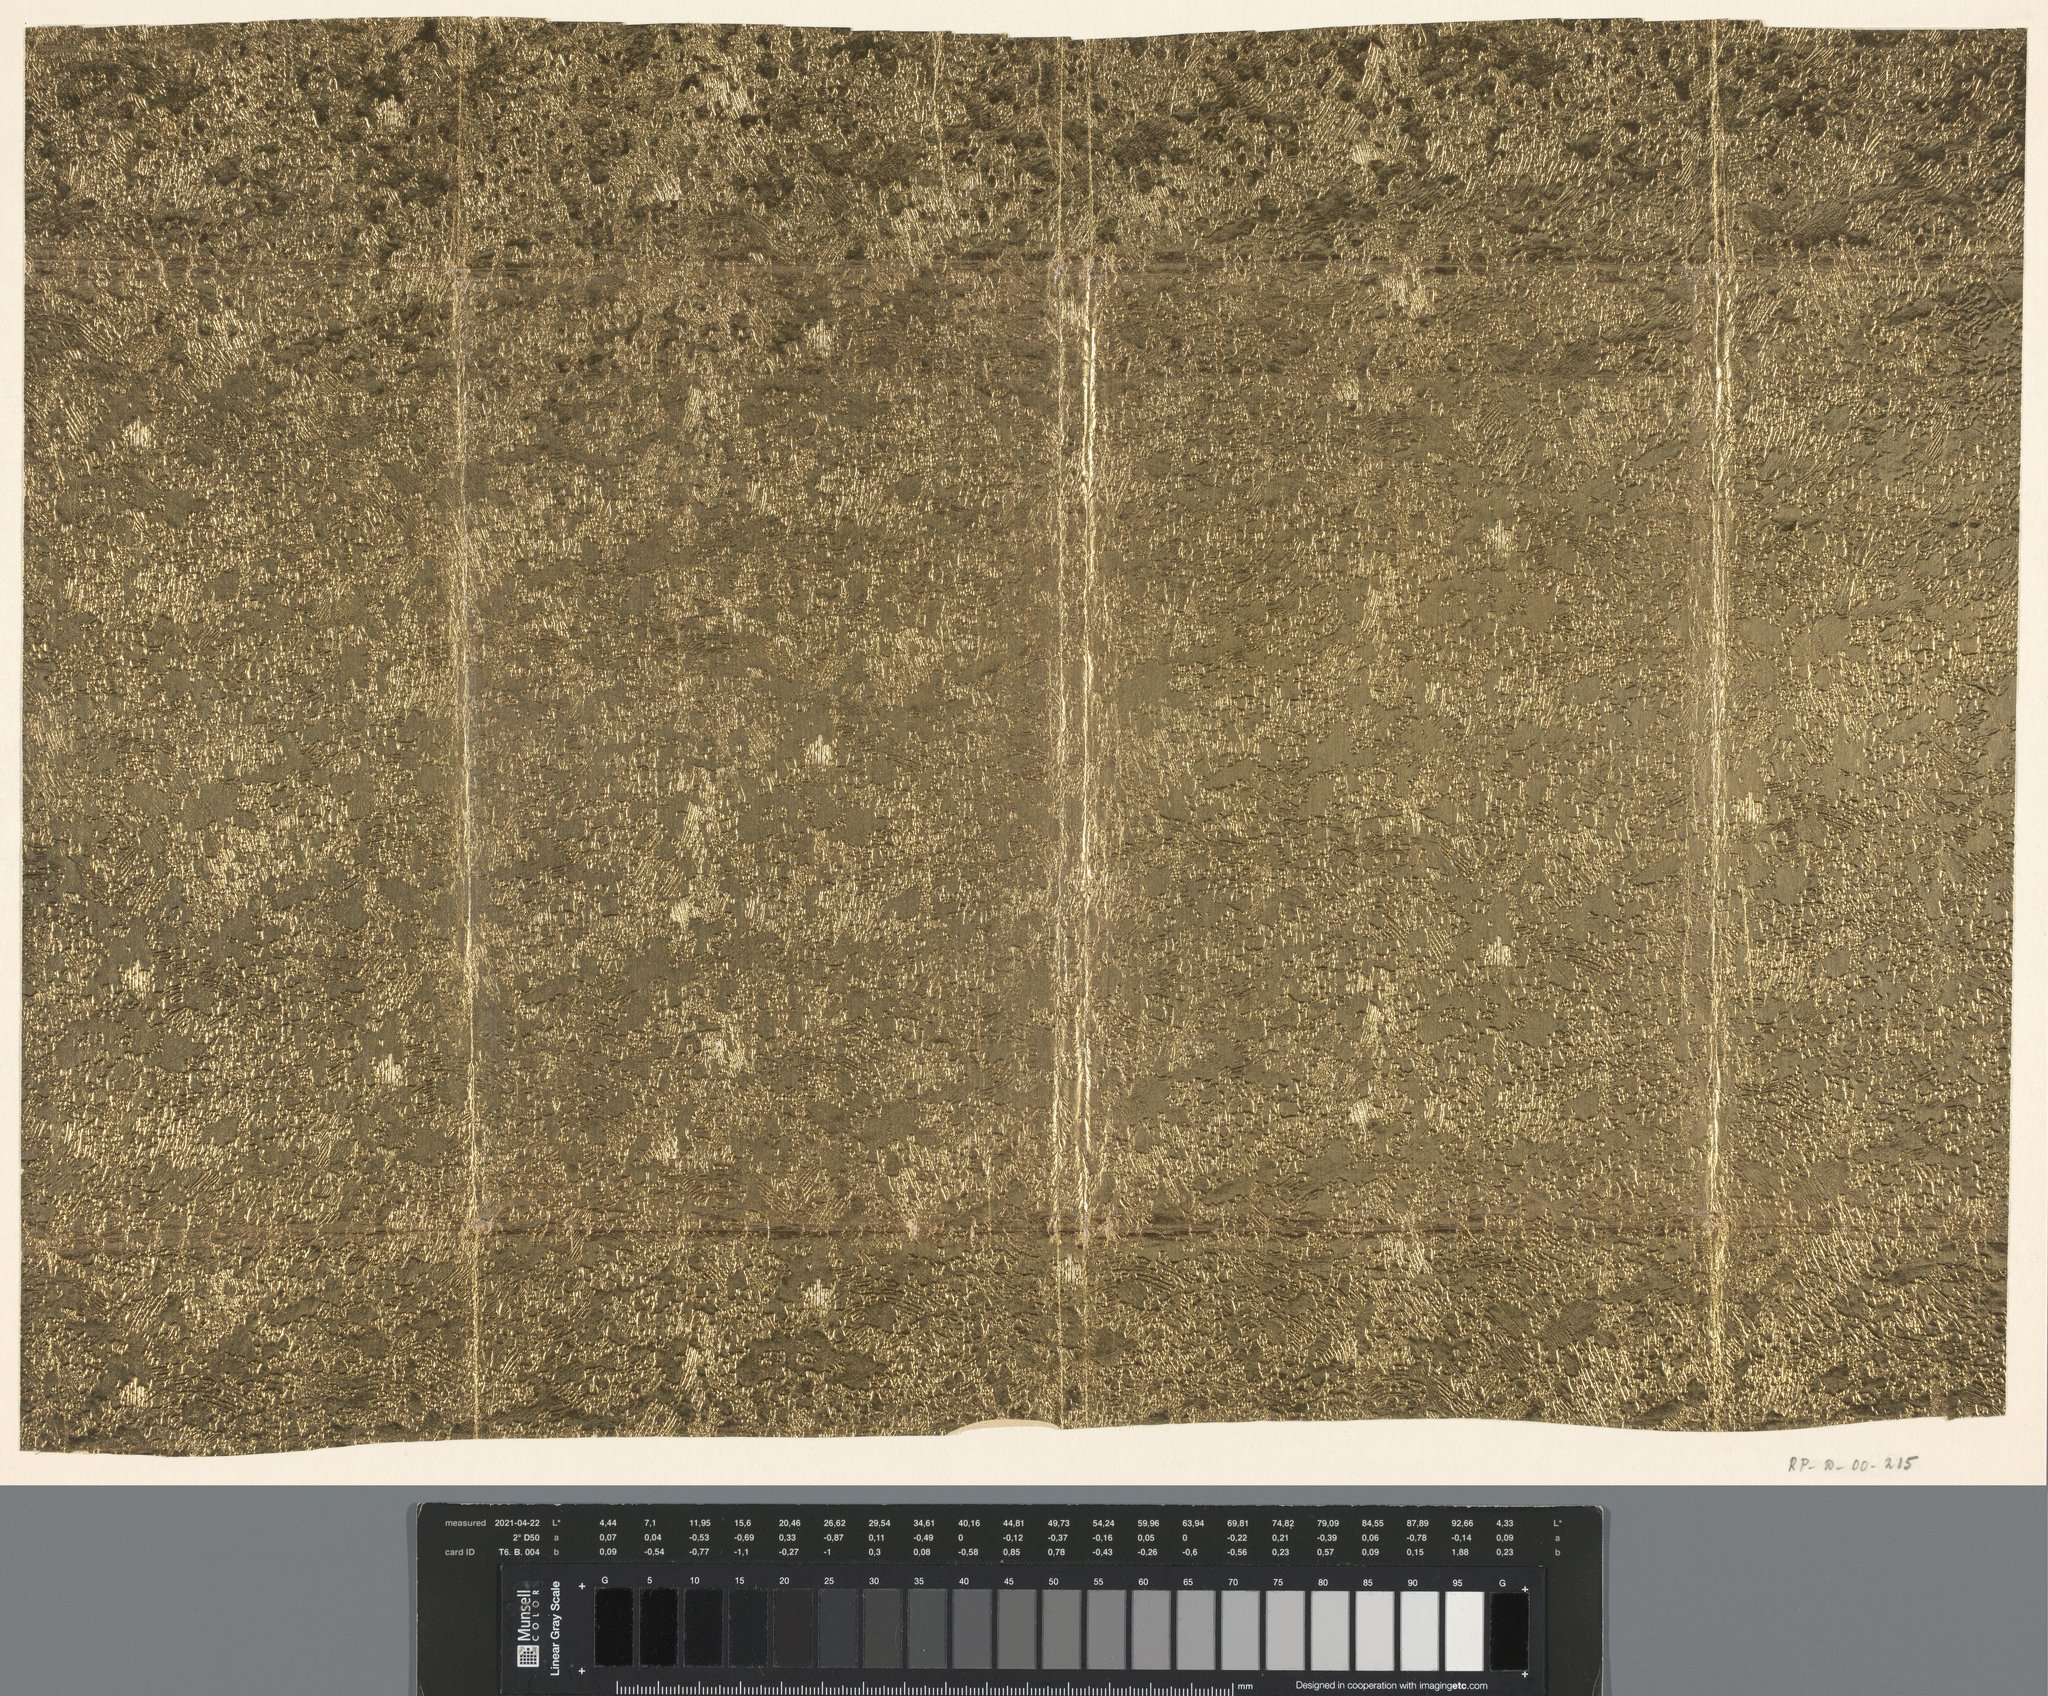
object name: metallic paper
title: Blad met onregelmatige structuur van veschillende vormen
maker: Anonymous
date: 1850-1920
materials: gold leaf, paper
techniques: gauffering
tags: fantasy ornament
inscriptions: collector's mark: Lugt 2228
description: Blad met onregelmatige amorfe structuur van lijnen en veschillende vormen, met vouwsporen.